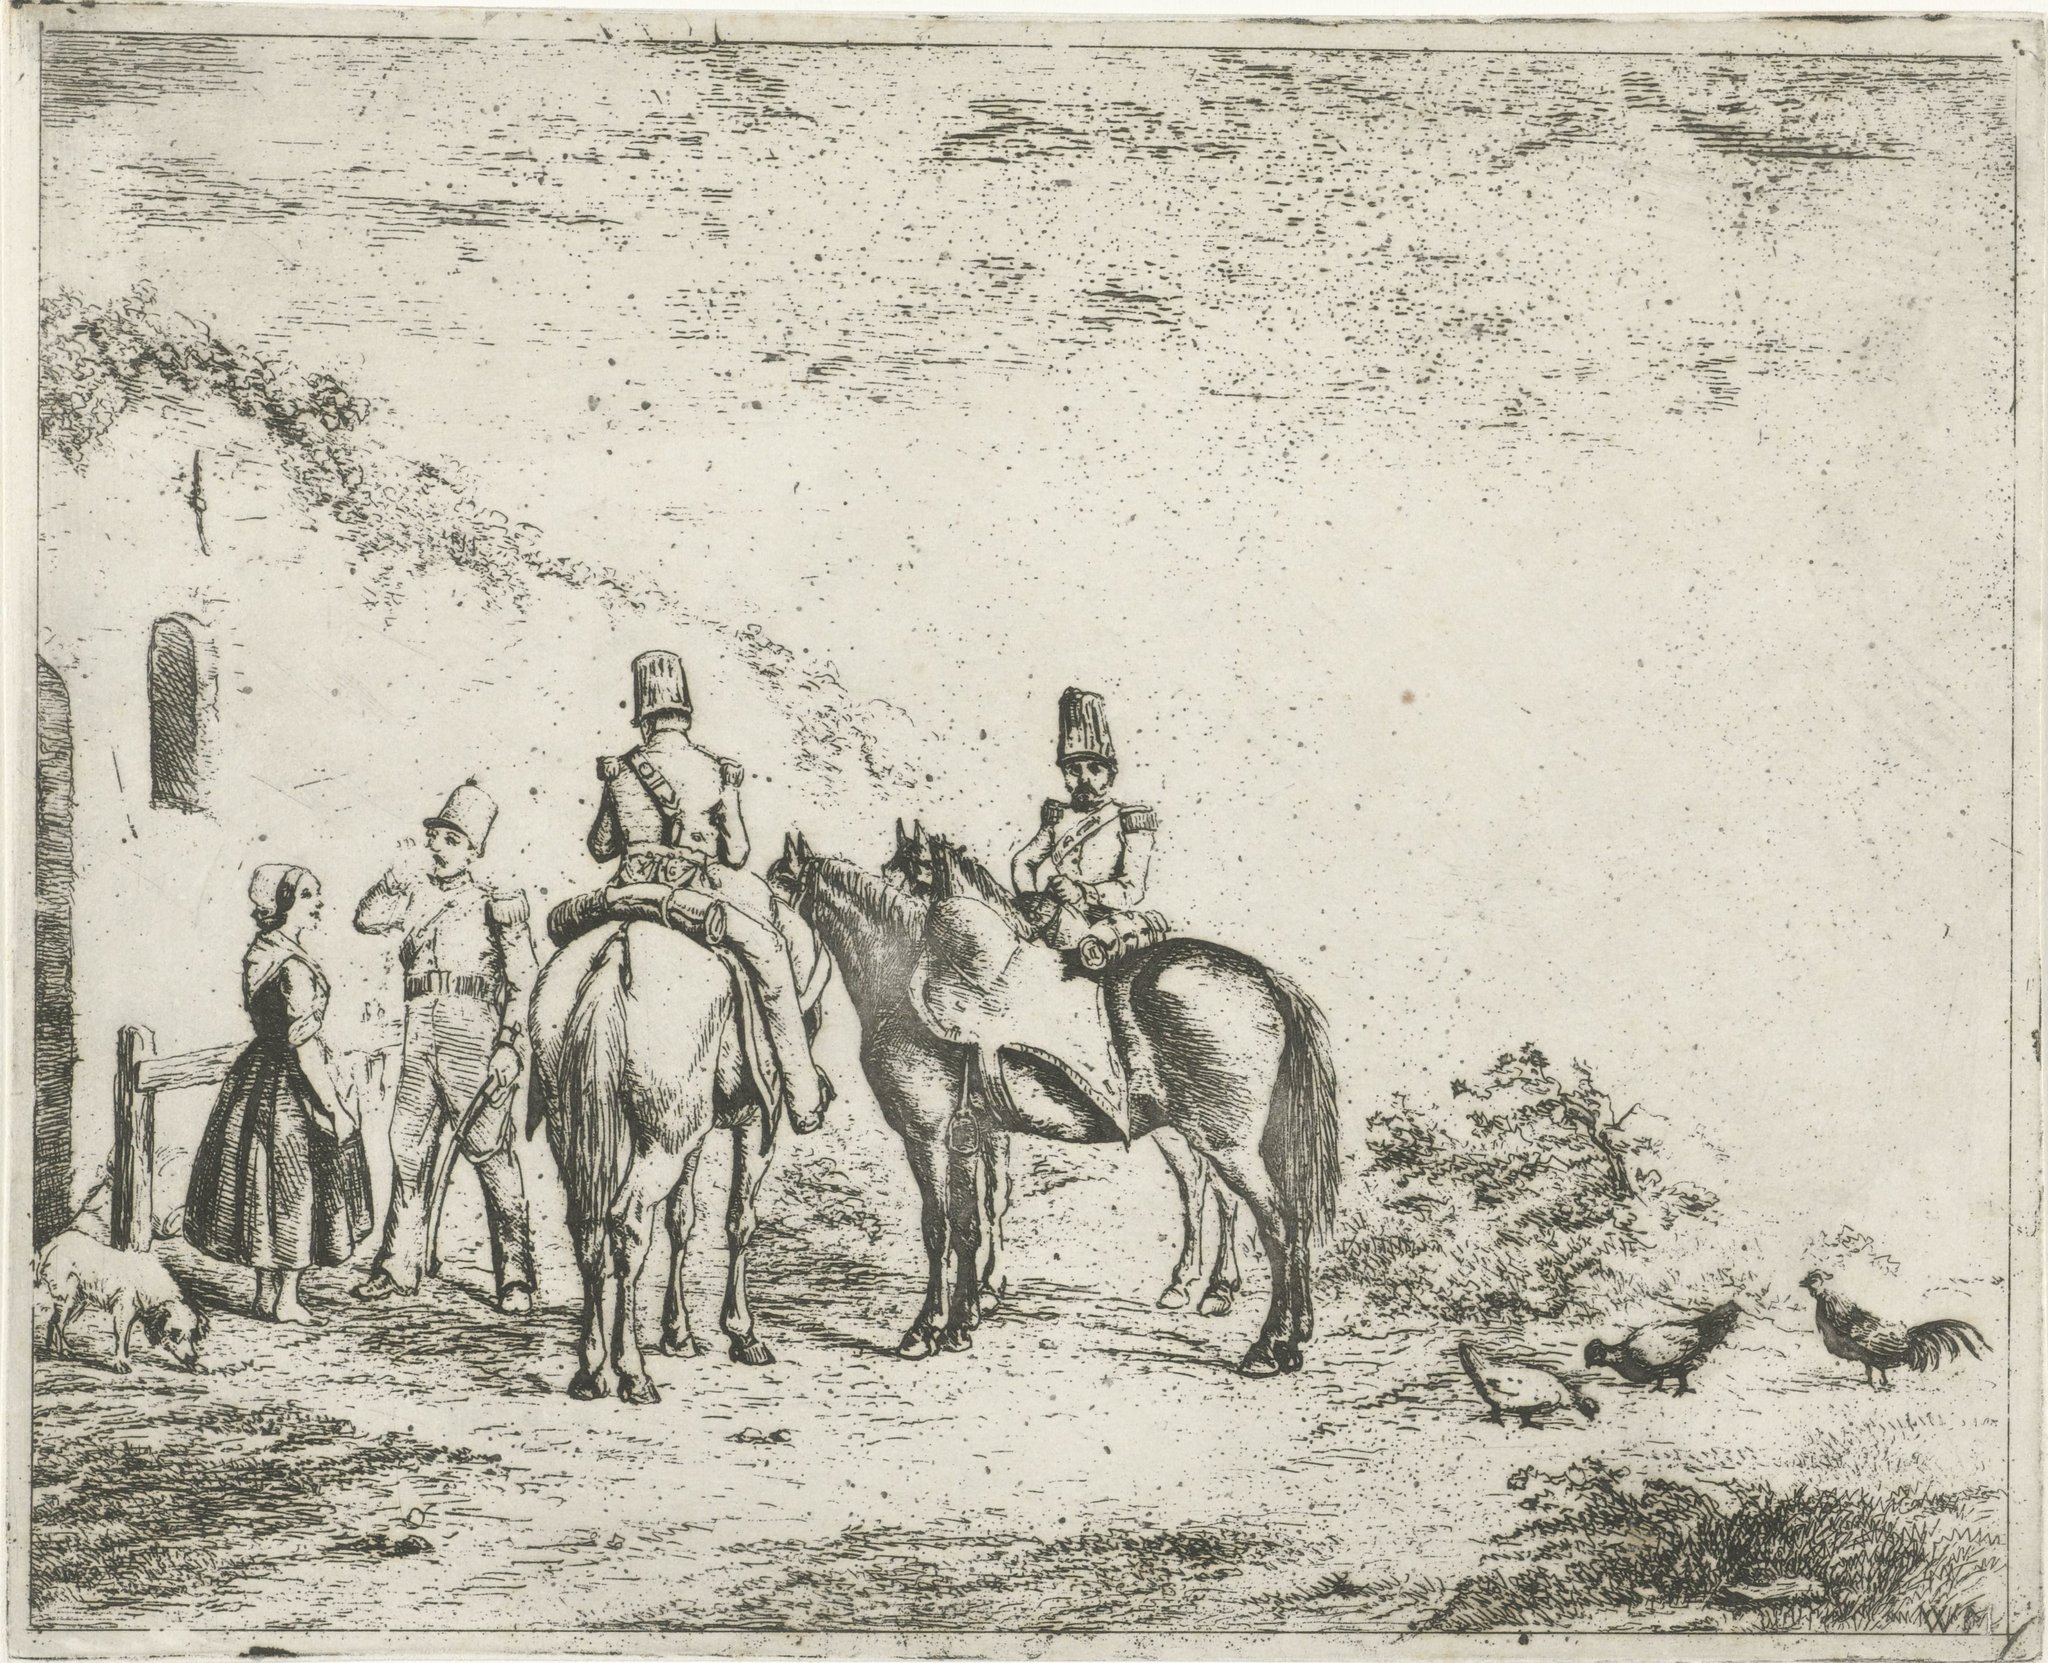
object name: print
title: Drie soldaten pauzeren bij een woning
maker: christiaan wilhelmus moorrees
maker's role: draughtsman, print maker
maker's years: 1801-1867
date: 1811-1867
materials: paper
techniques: etching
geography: netherlands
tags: fowl (cock, hen, chicken, etc.), giving drink, military discipline (+ cavalry, horsemen)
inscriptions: collector's mark: Lugt 2228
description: Twee soldaten te paard bij een woning. Een derde drinkt een beker leeg, die hem door een boerenmeisje is aangeboden. Naast het meisje een hond, rechts kippen.